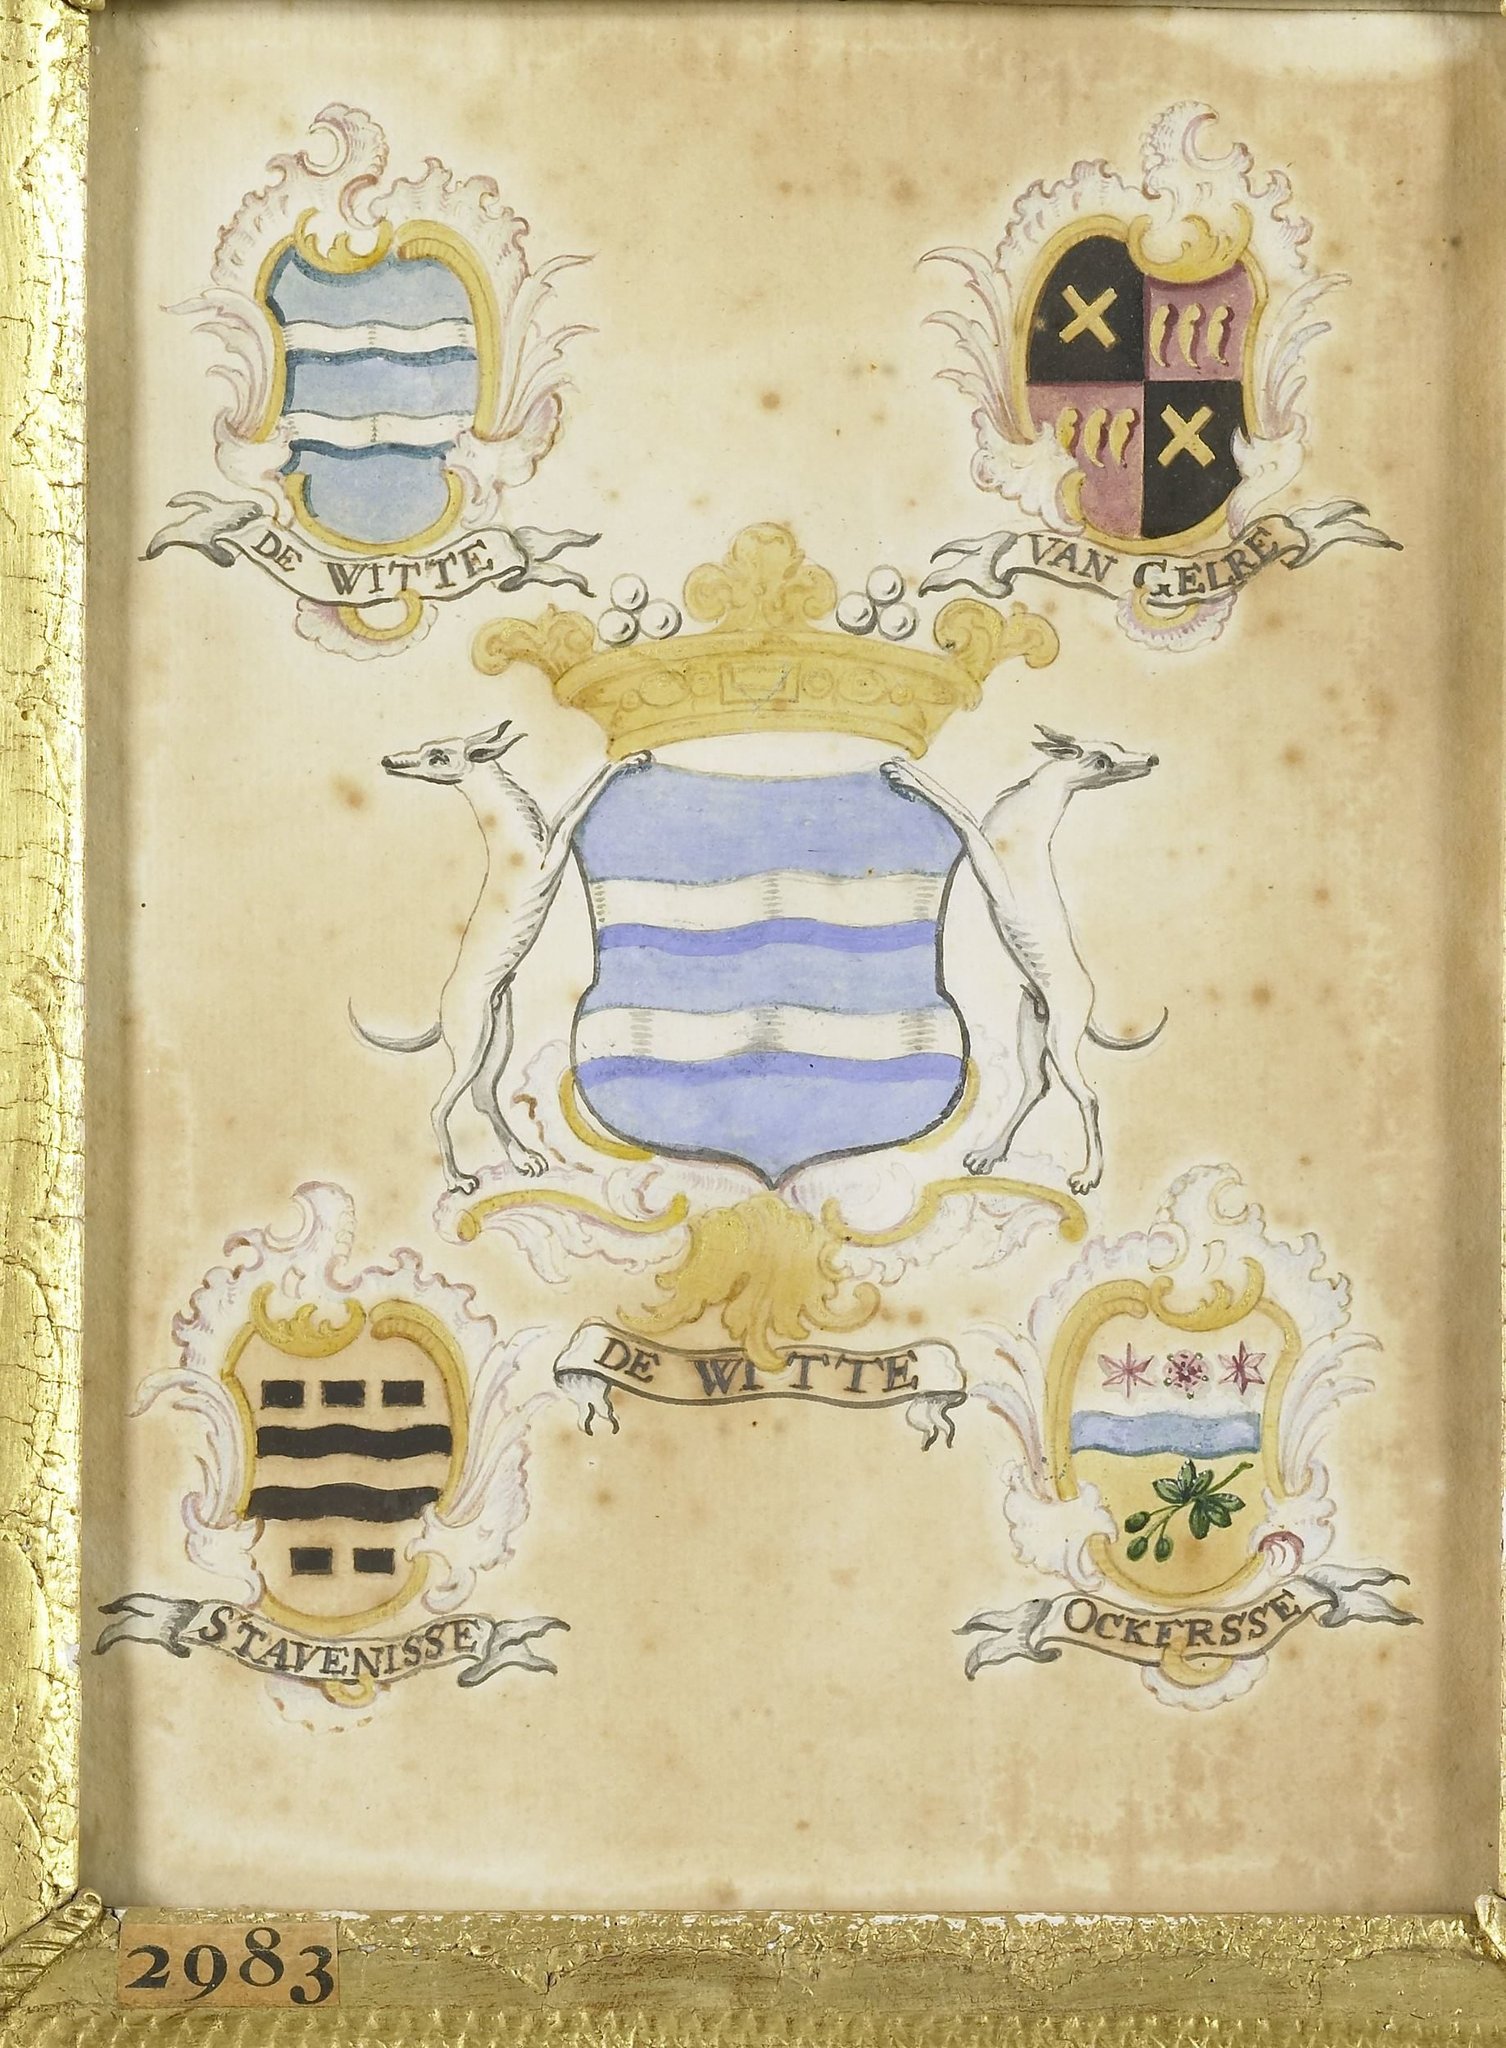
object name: heraldisch object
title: Het wapen van Anna Jacoba de Witte, echtgenote van Jacob Verheye van Citters, met de wapens van haar vier grootouders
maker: Anonymous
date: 1750-1799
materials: paper, watercolor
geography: northern netherlands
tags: the hague, armorial bearing, heraldry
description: Het wapen van Anna Jacoba de Witte (1758-1796), echtgenote van Jacob Verheye van Citters, met de wapens van haar vier grootouders: de Witte, Stavenisse, van Gelre en Ockersse. Onderdeel van een reeks wapens behorend bij de schenking Jonkheer J. de Witte van Citters, Den Haag, 1876. Onderdeel van de collectie heraldische objecten.